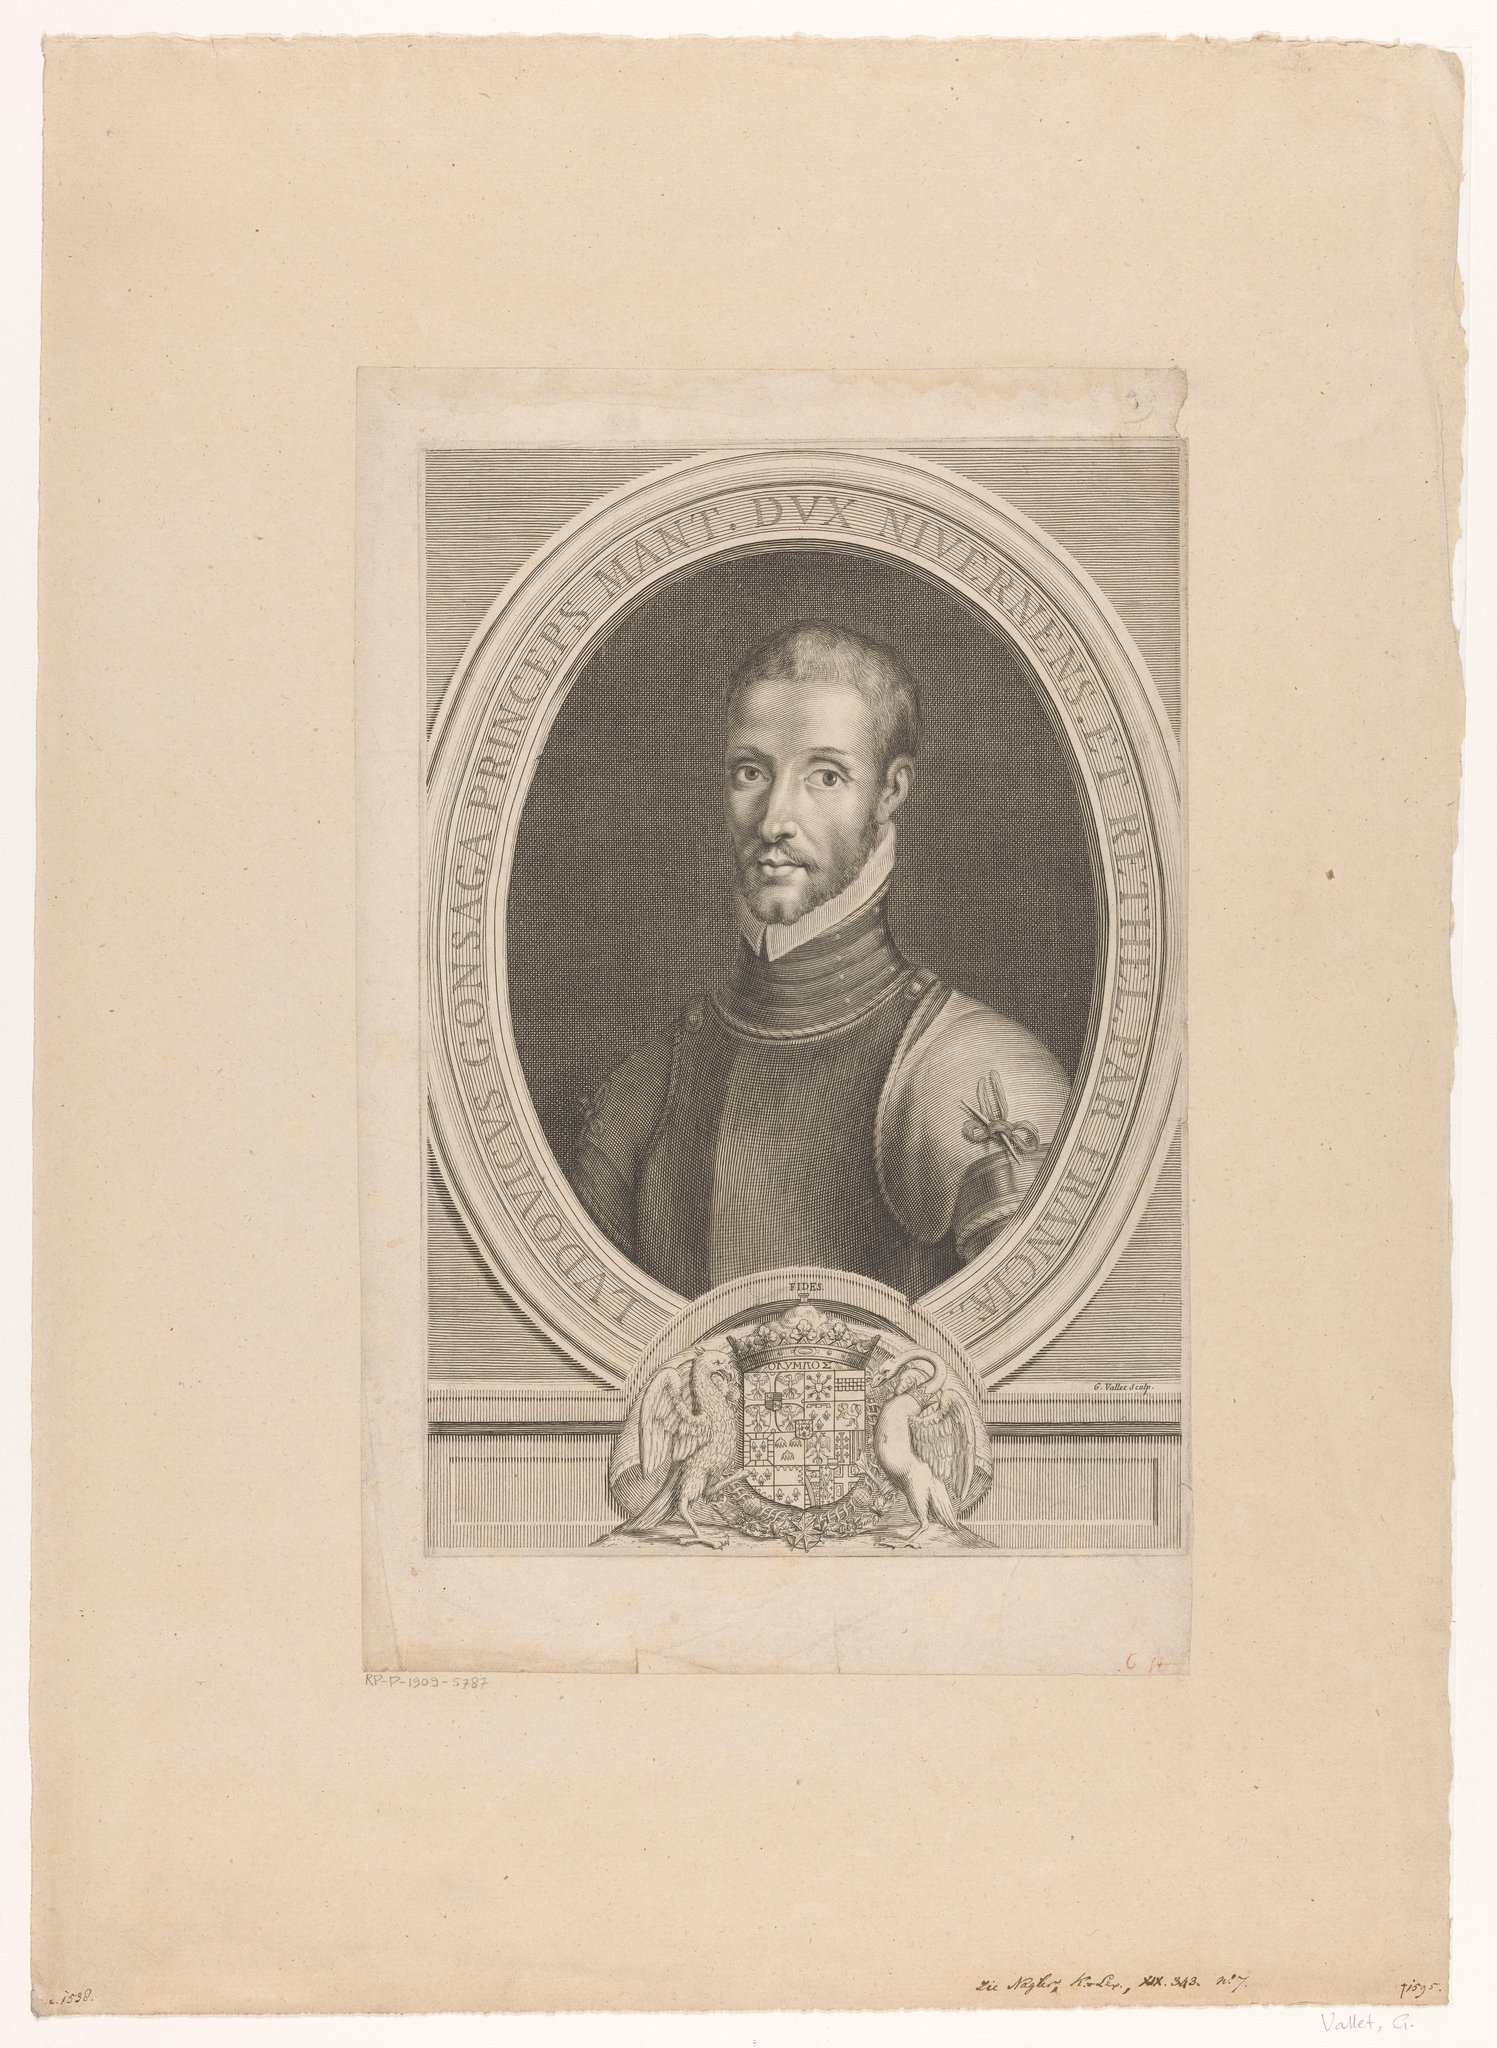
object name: print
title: Portret van Lodewijk Gonzaga, hertog van Nevers en Rethel in een ovale lijst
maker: guillaume vallet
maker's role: print maker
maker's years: 1632-1704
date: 1642-1704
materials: paper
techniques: engraving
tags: historical persons, armorial bearing, heraldry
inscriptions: collector's mark: Lugt 2228